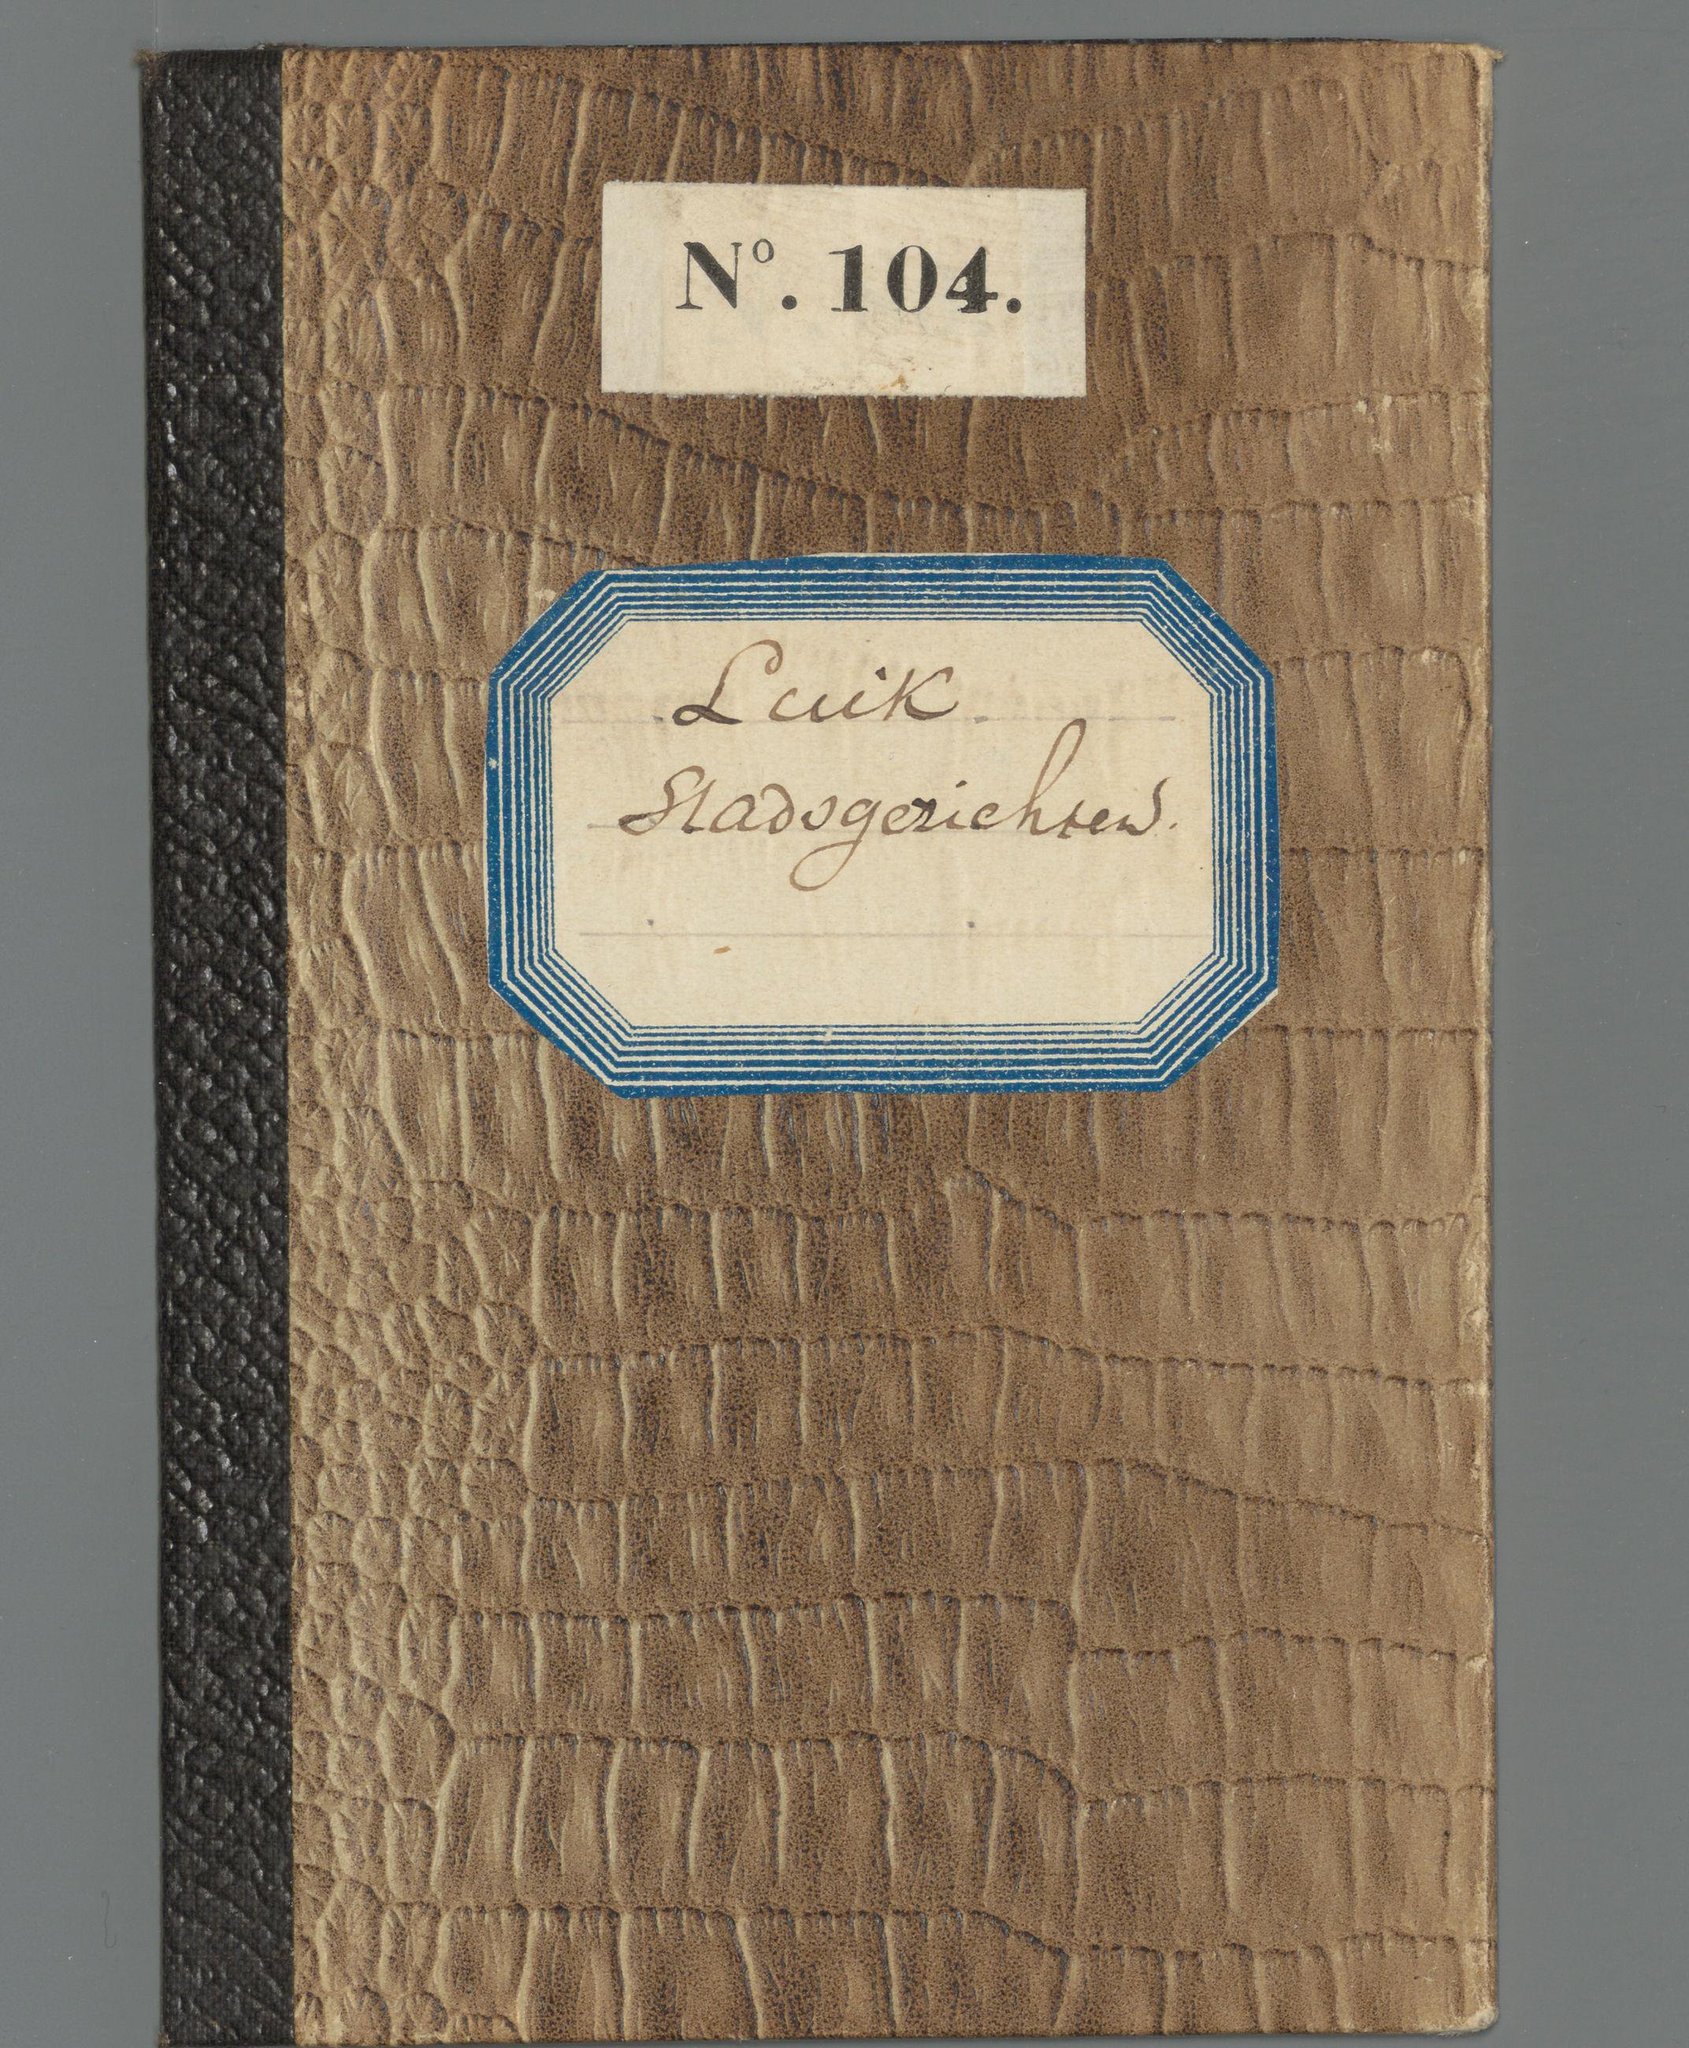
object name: wrapper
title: Luik stadsgezichten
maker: Anonymous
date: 1900-1950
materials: cardboard, ink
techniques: pen